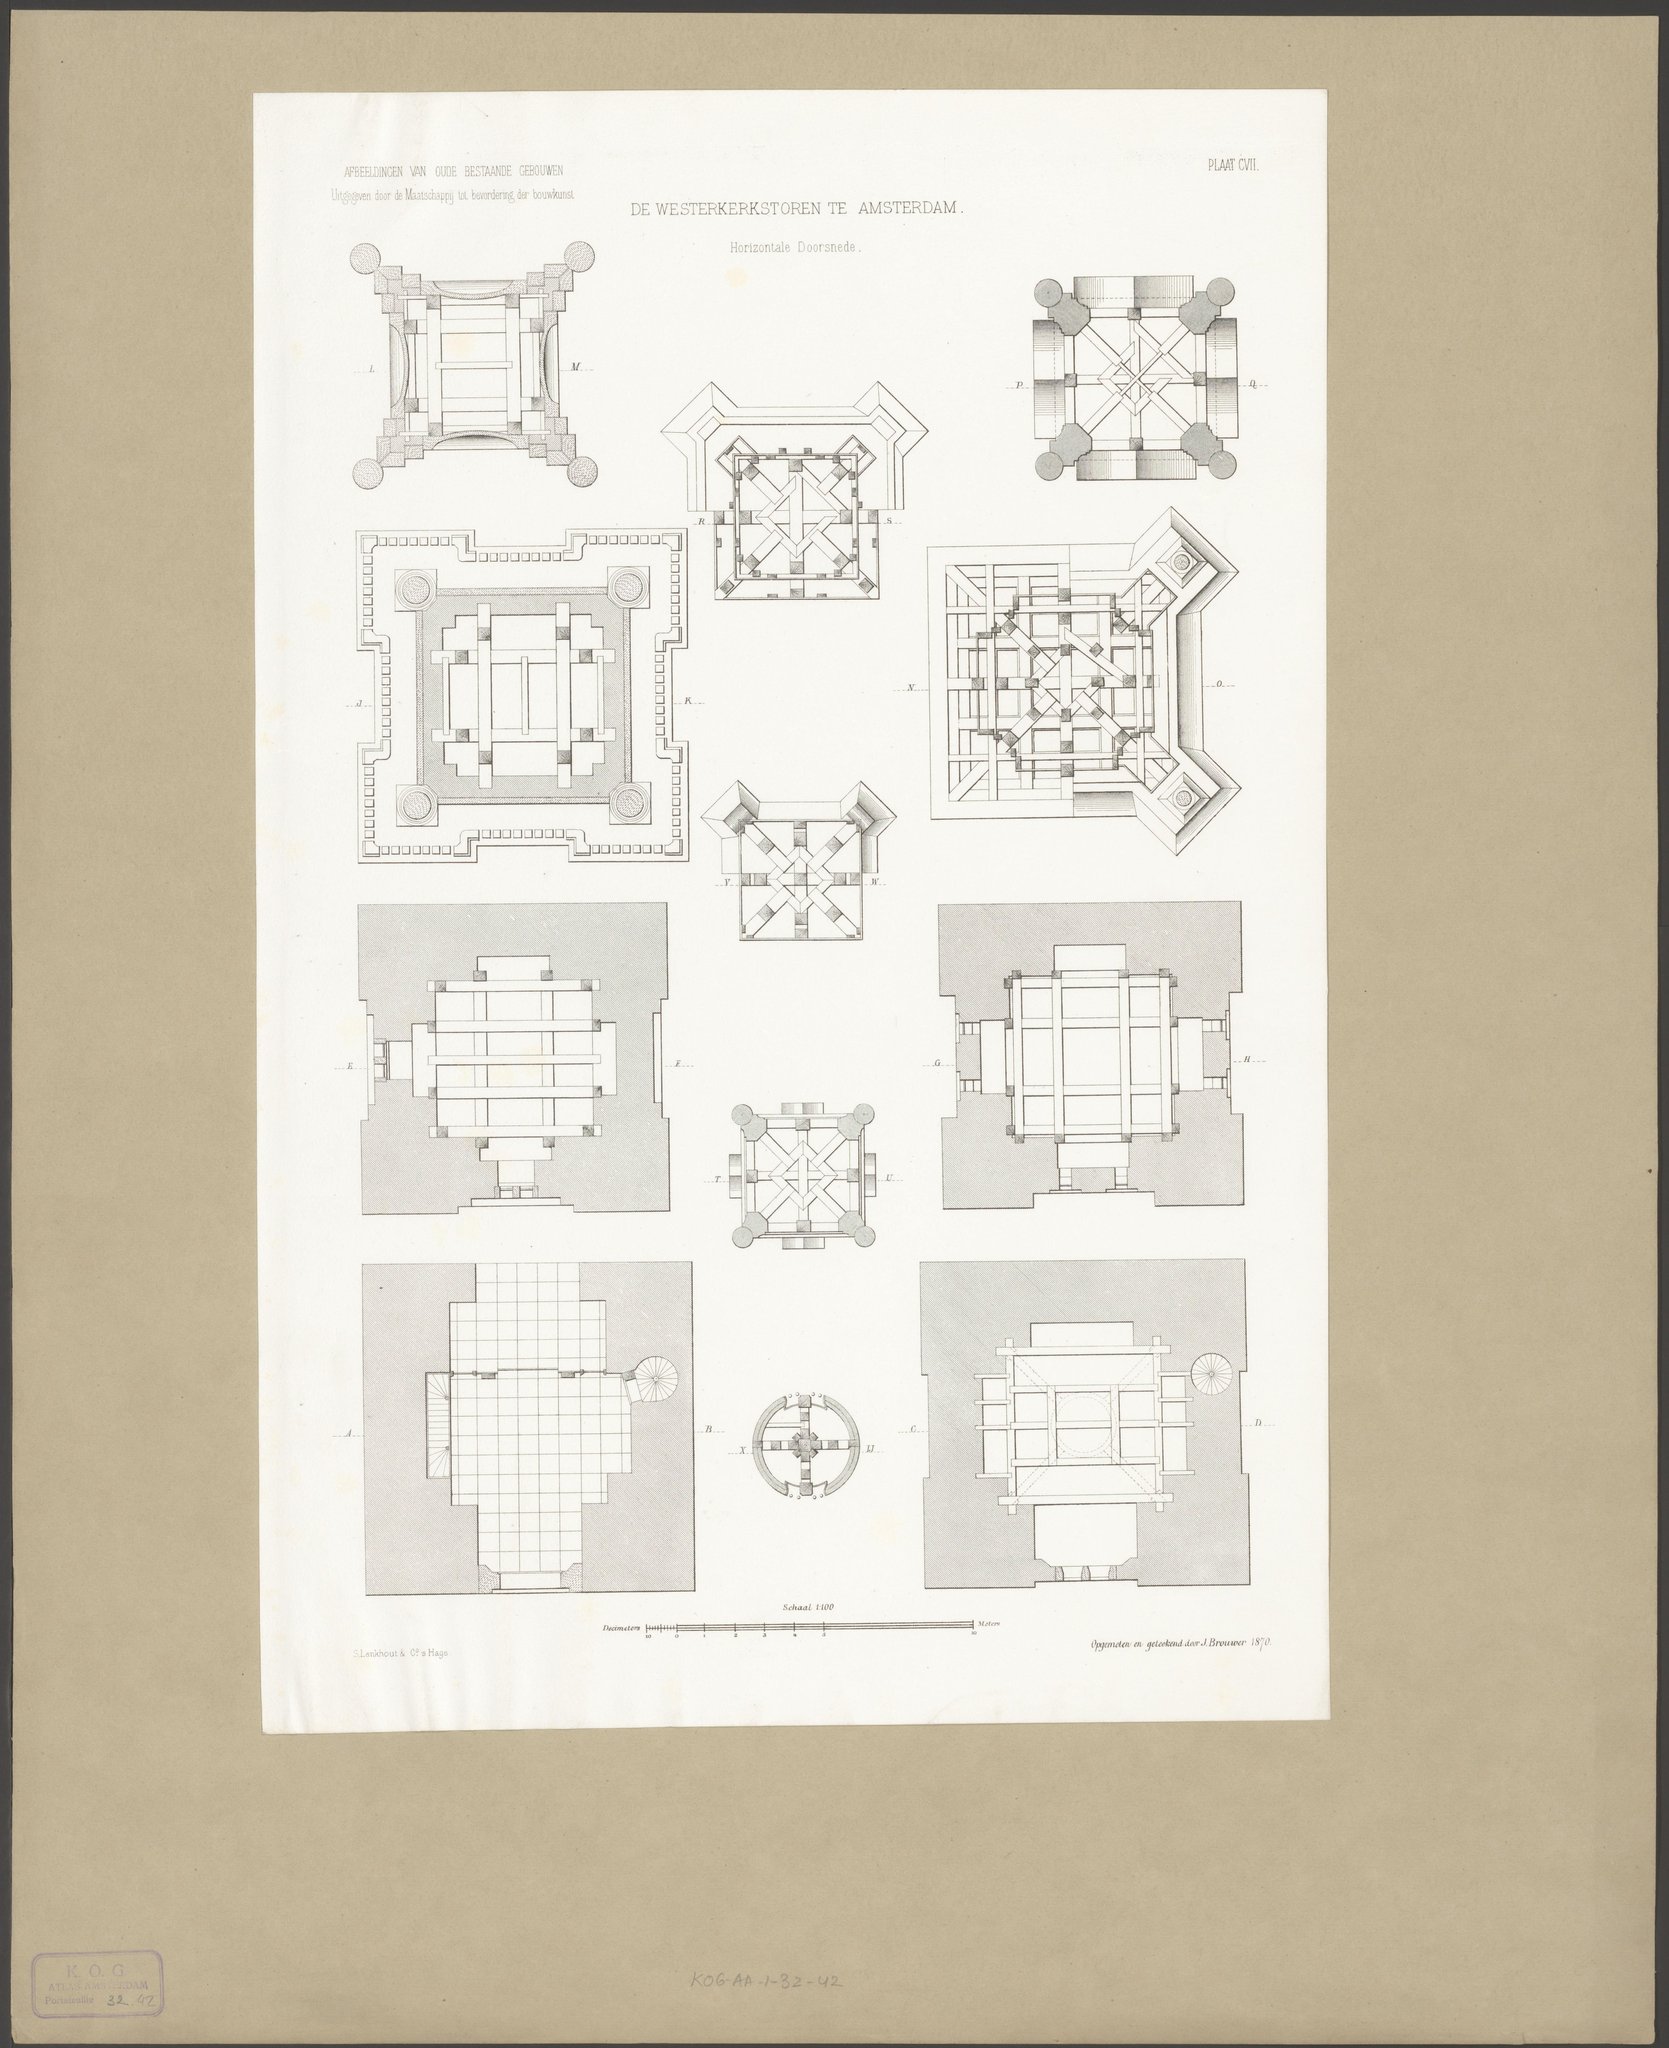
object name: photomechanical print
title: De Westerkerkstoren te Amsterdam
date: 1870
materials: paper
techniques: photolithography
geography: amsterdam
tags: plan ~ architecture, parts of church exterior and annexes: tower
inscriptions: collector's mark: ‘32.42’ Lugt 1641b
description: Rechtsboven genummerd: CVII. Onderaan een schaalroede. Onderwerpsrubriek binnen de Atlas Amsterdam: Kerkwezen: Hervormde Gemeente: Westerkerk.